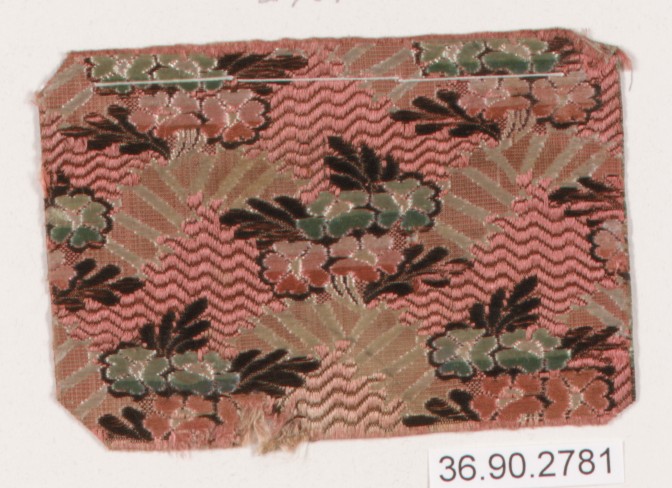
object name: piece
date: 1801-1900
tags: flowers,leaves